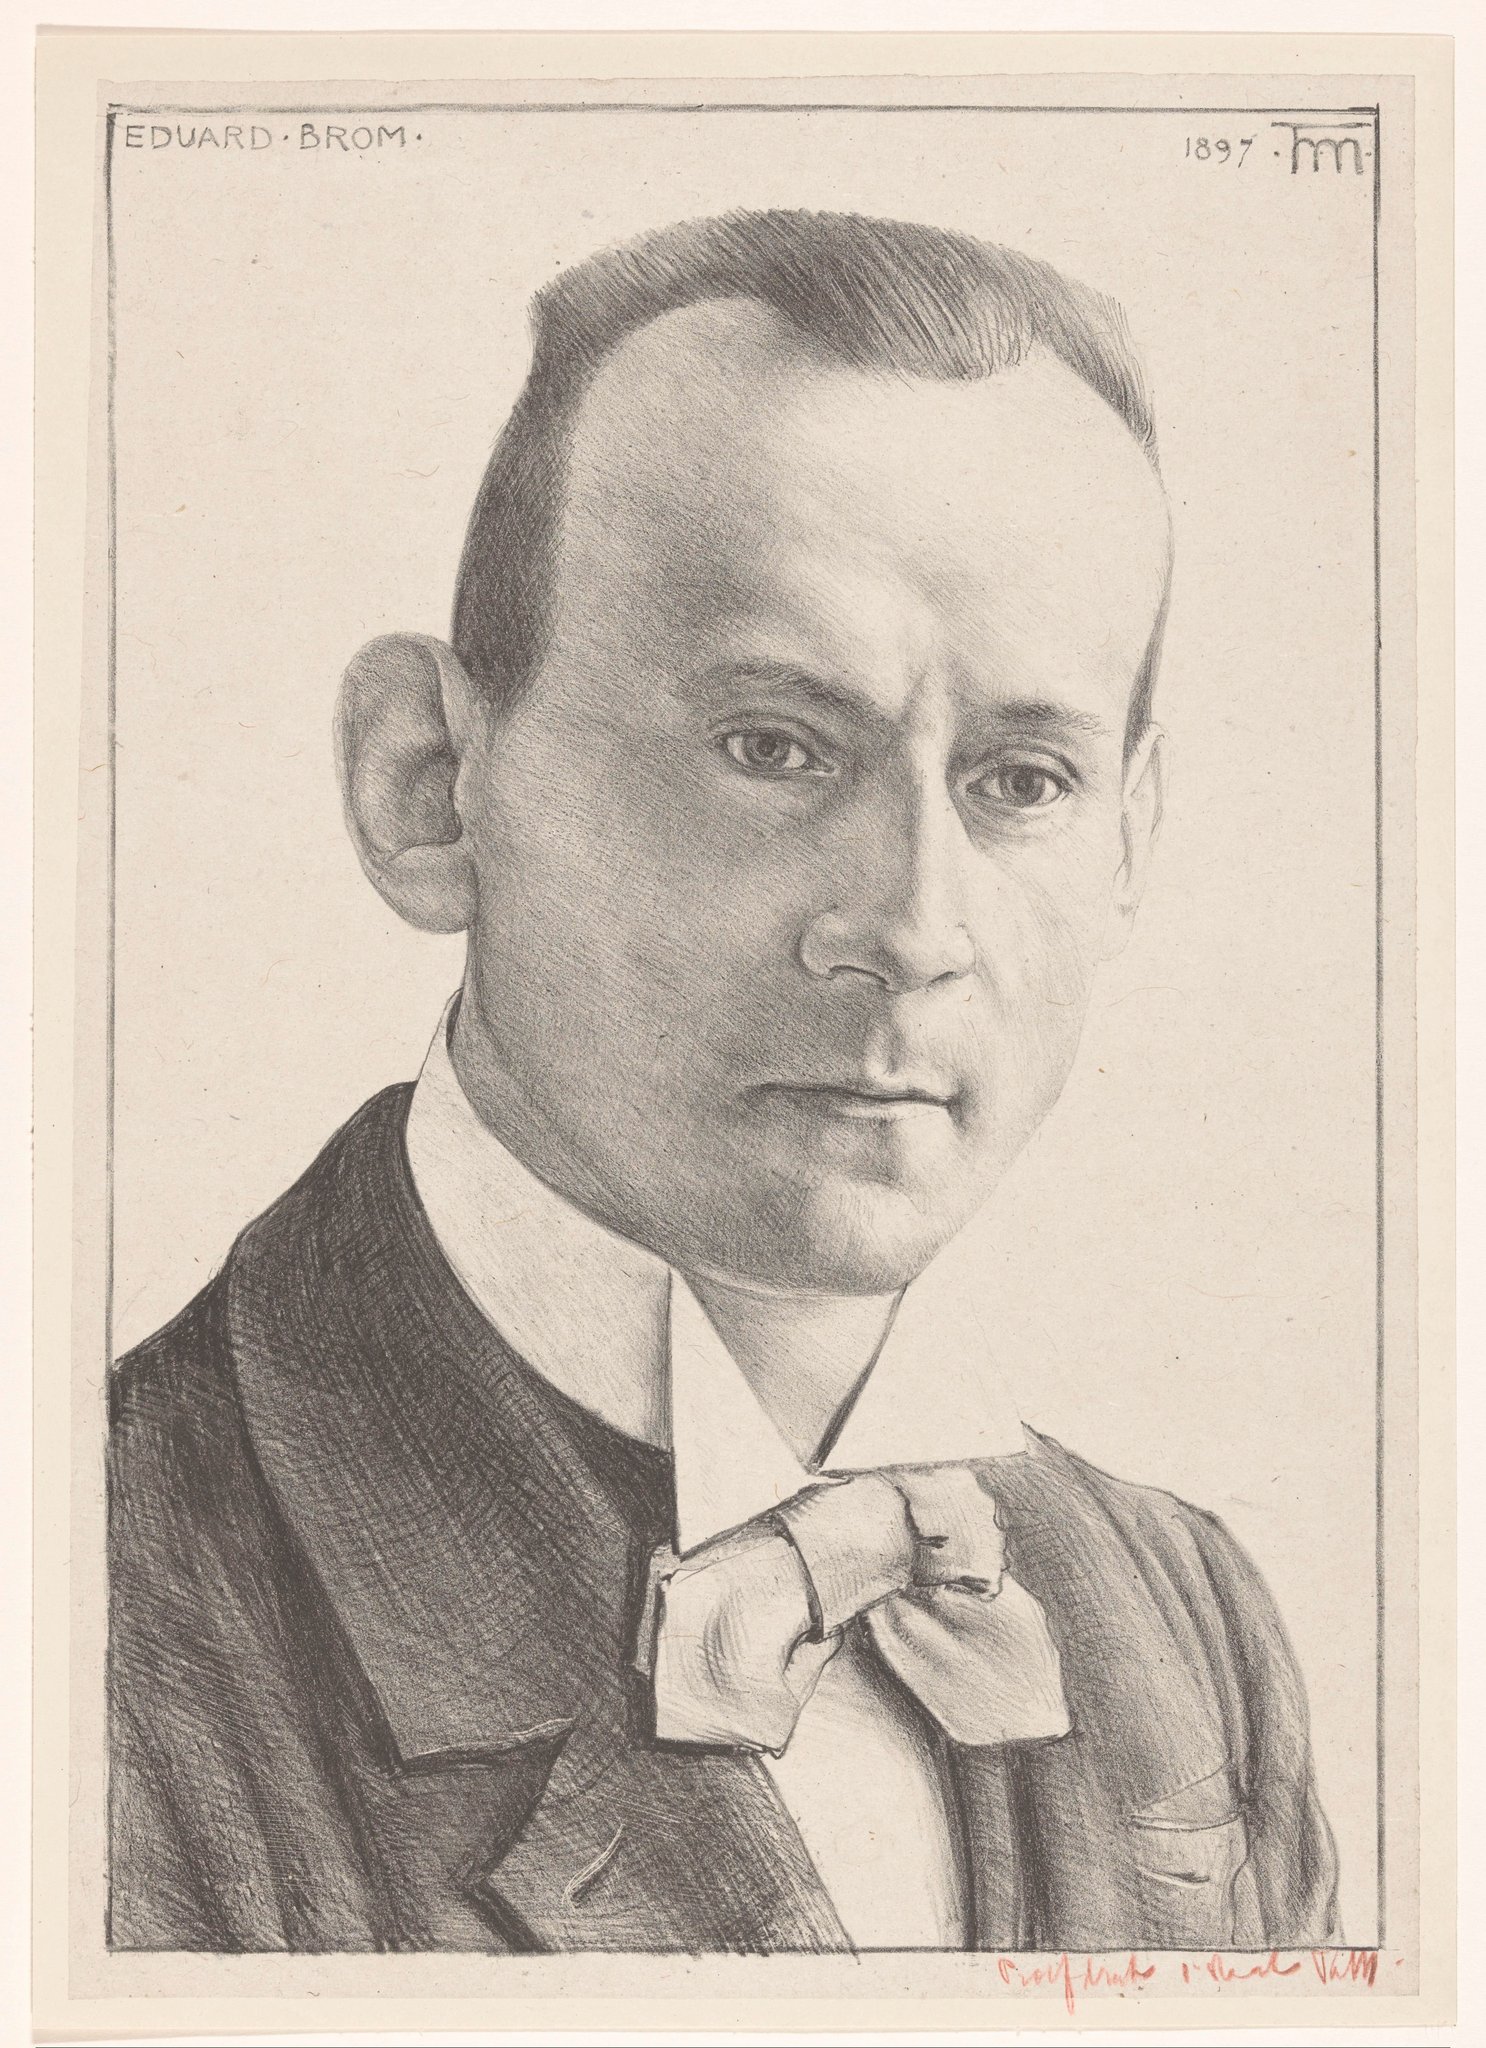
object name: print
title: Portret van Eduard Brom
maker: theo molkenboer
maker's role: draughtsman, print maker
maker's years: 1871-1920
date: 1897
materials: paper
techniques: lithograph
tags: amsterdam, portrait of a writer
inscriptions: collector's mark: Lugt 2228